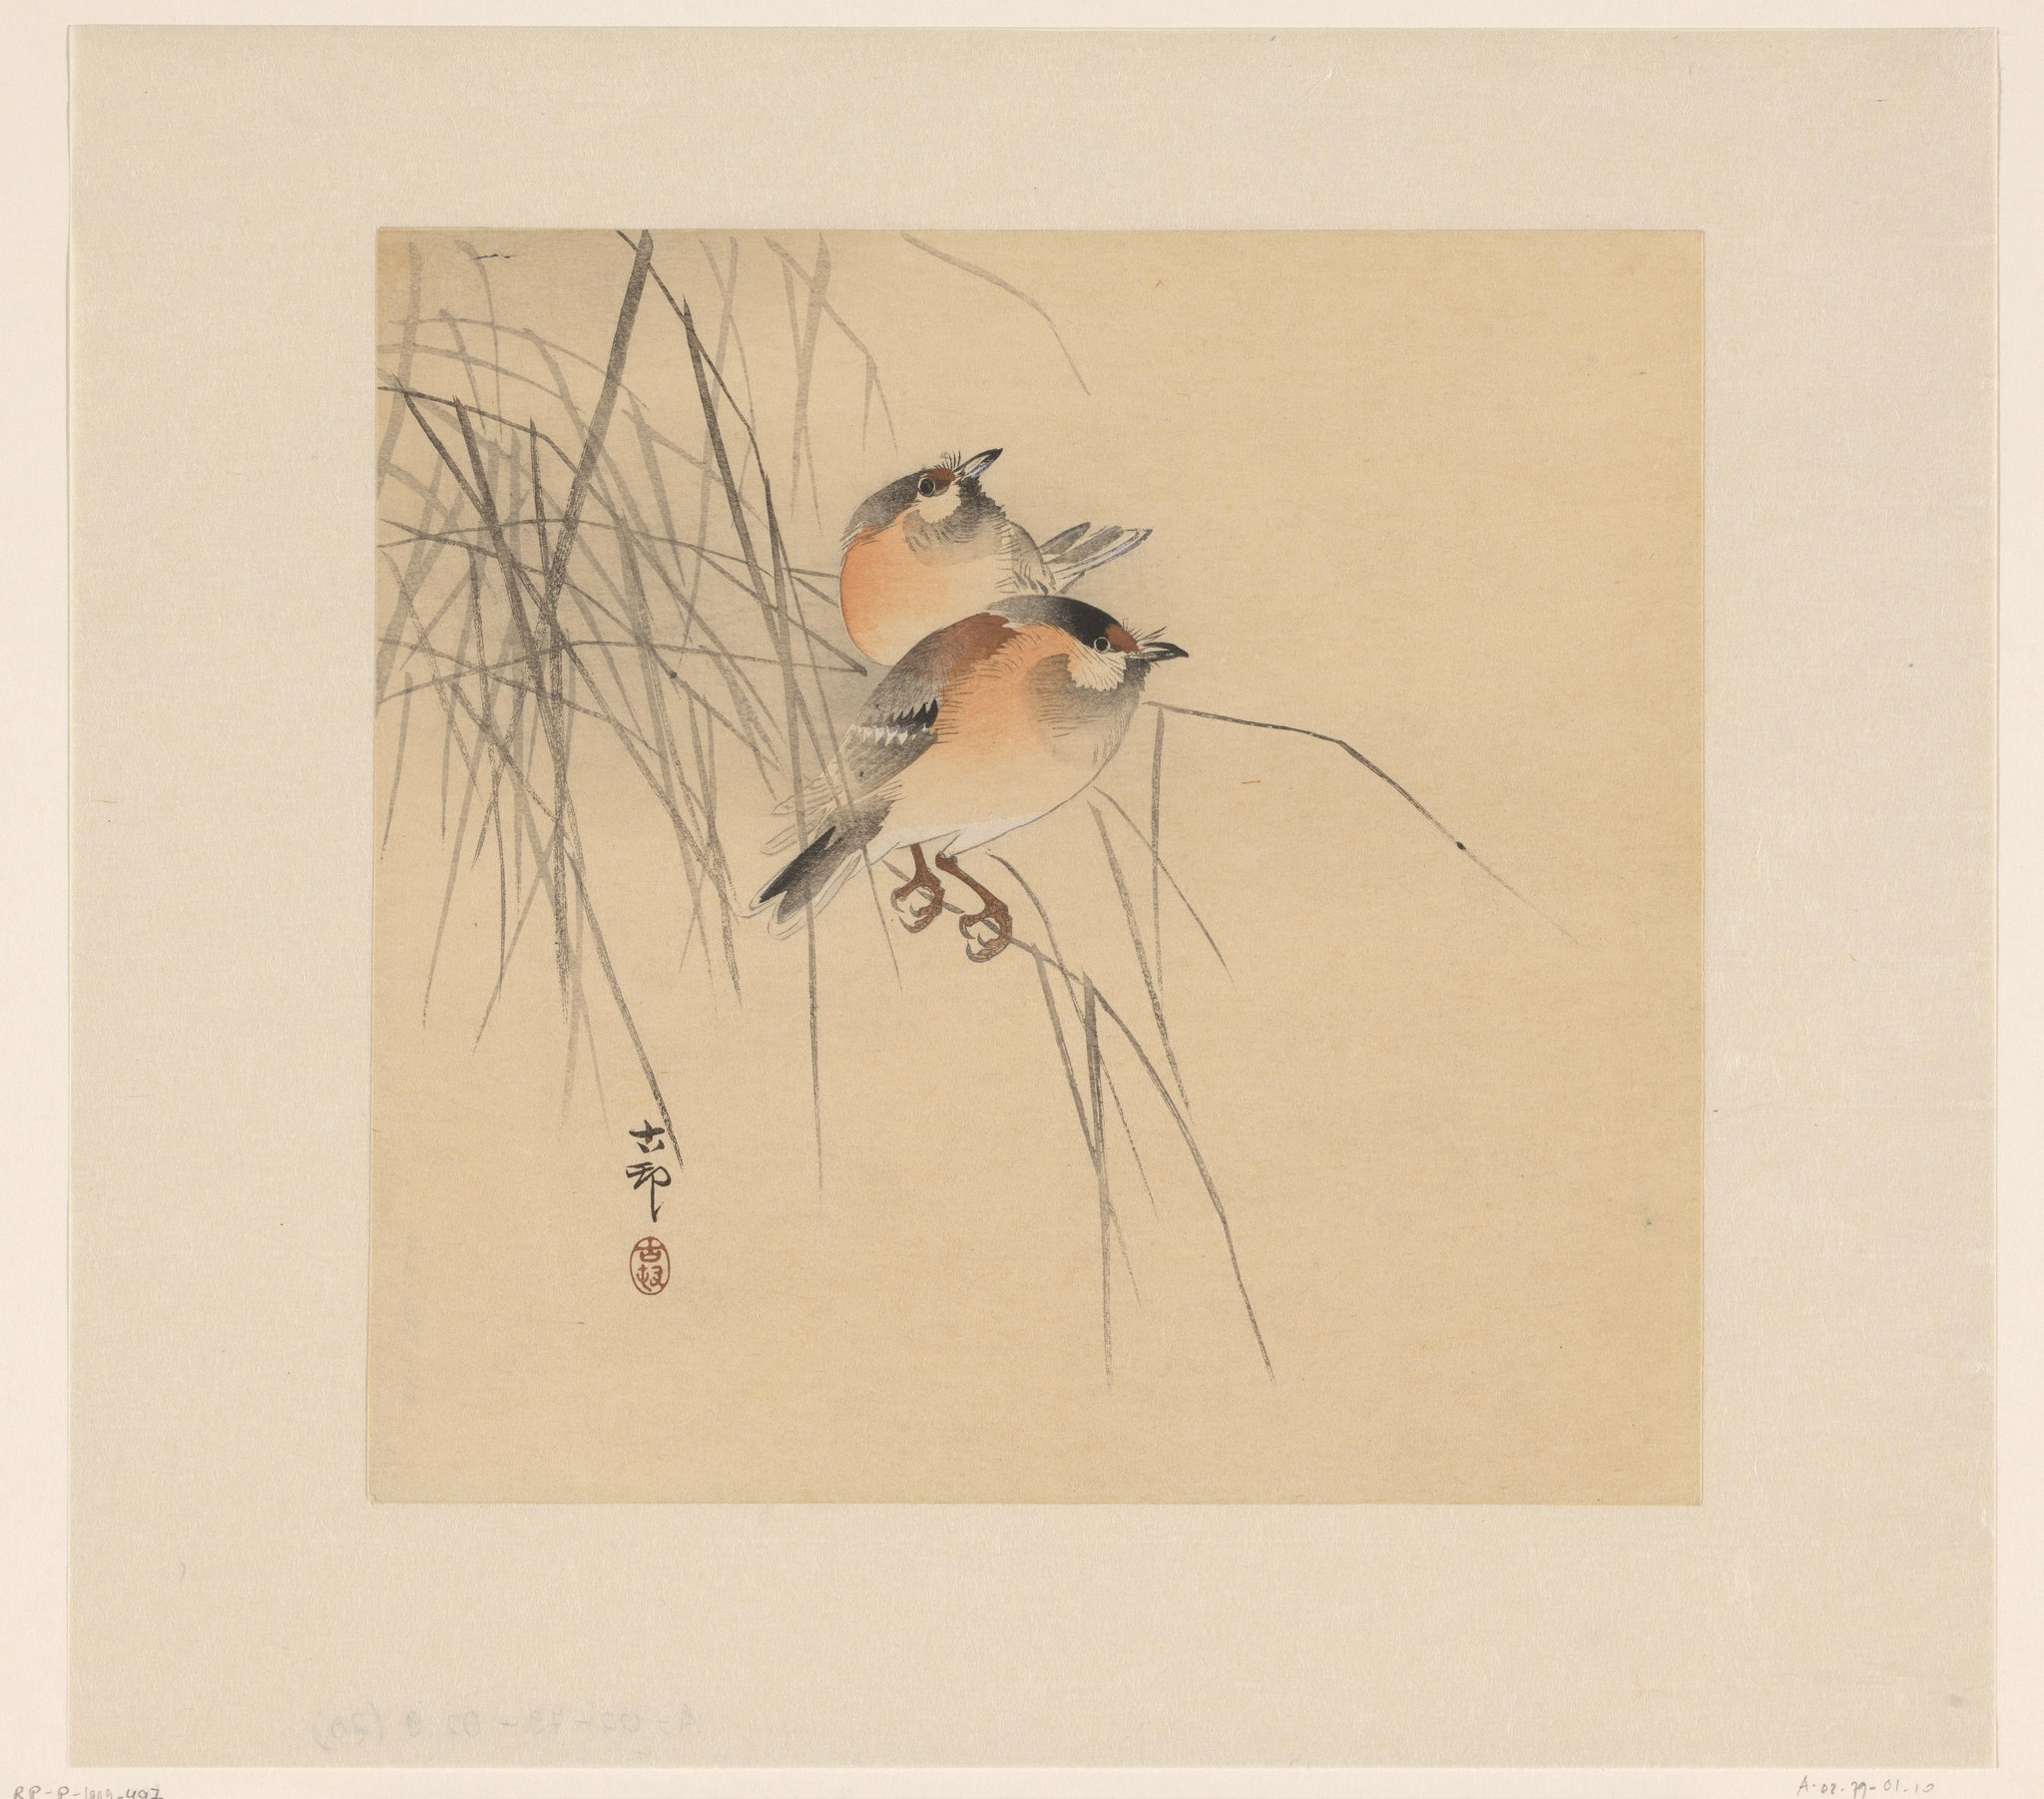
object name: print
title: Twee mezen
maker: ohara koson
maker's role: print maker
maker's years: 1877-1945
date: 1900-1930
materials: paper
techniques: woodcut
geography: japan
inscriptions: collector's mark: Lugt 2228